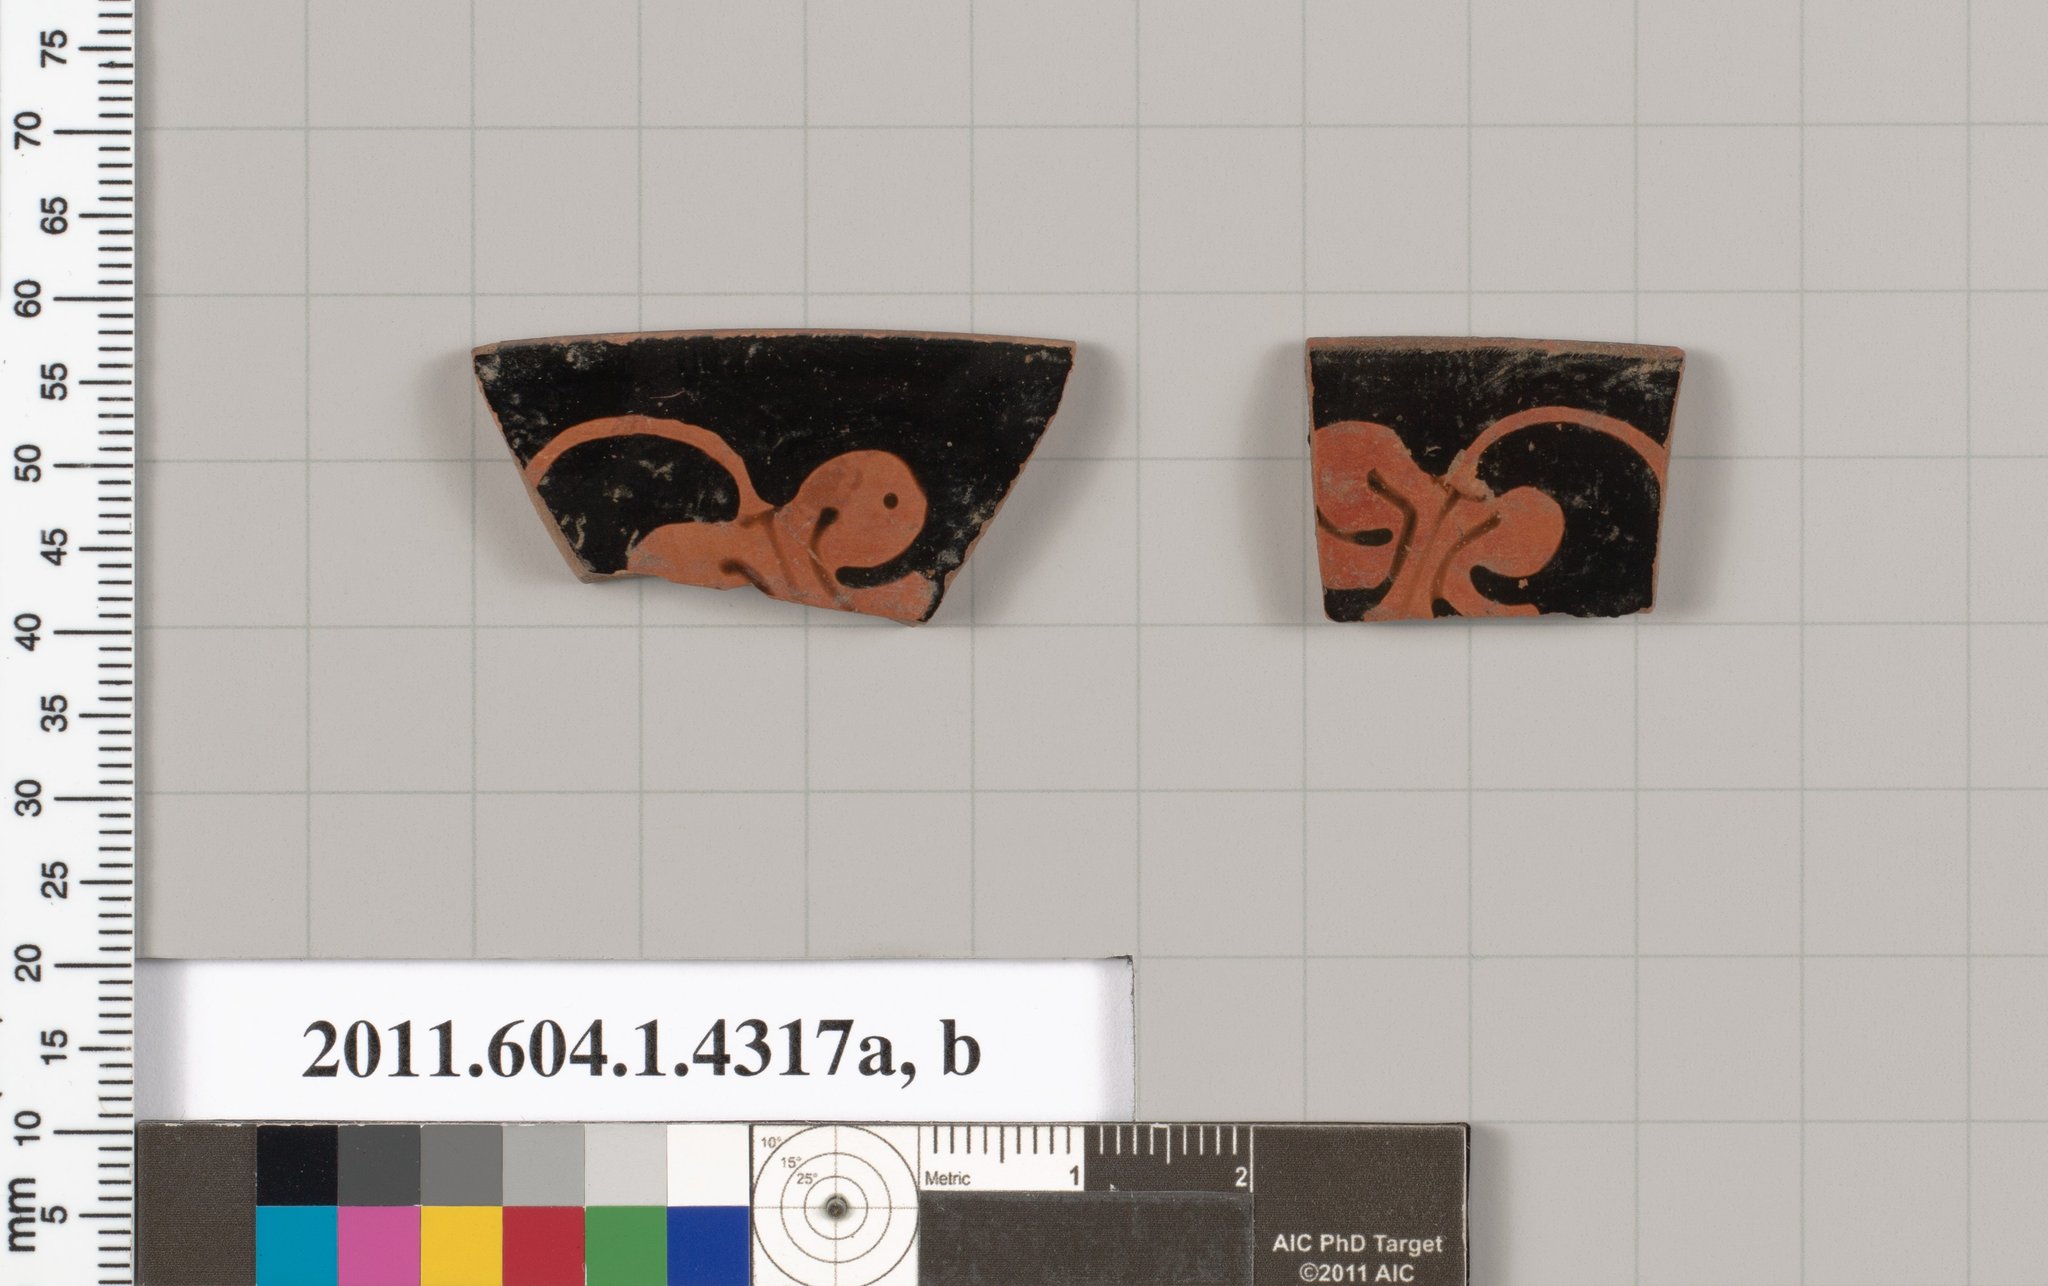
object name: kylix fragment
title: Terracotta rim fragments of kylikes (drinking cups)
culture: greek, attic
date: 500-451 BCE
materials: terracotta